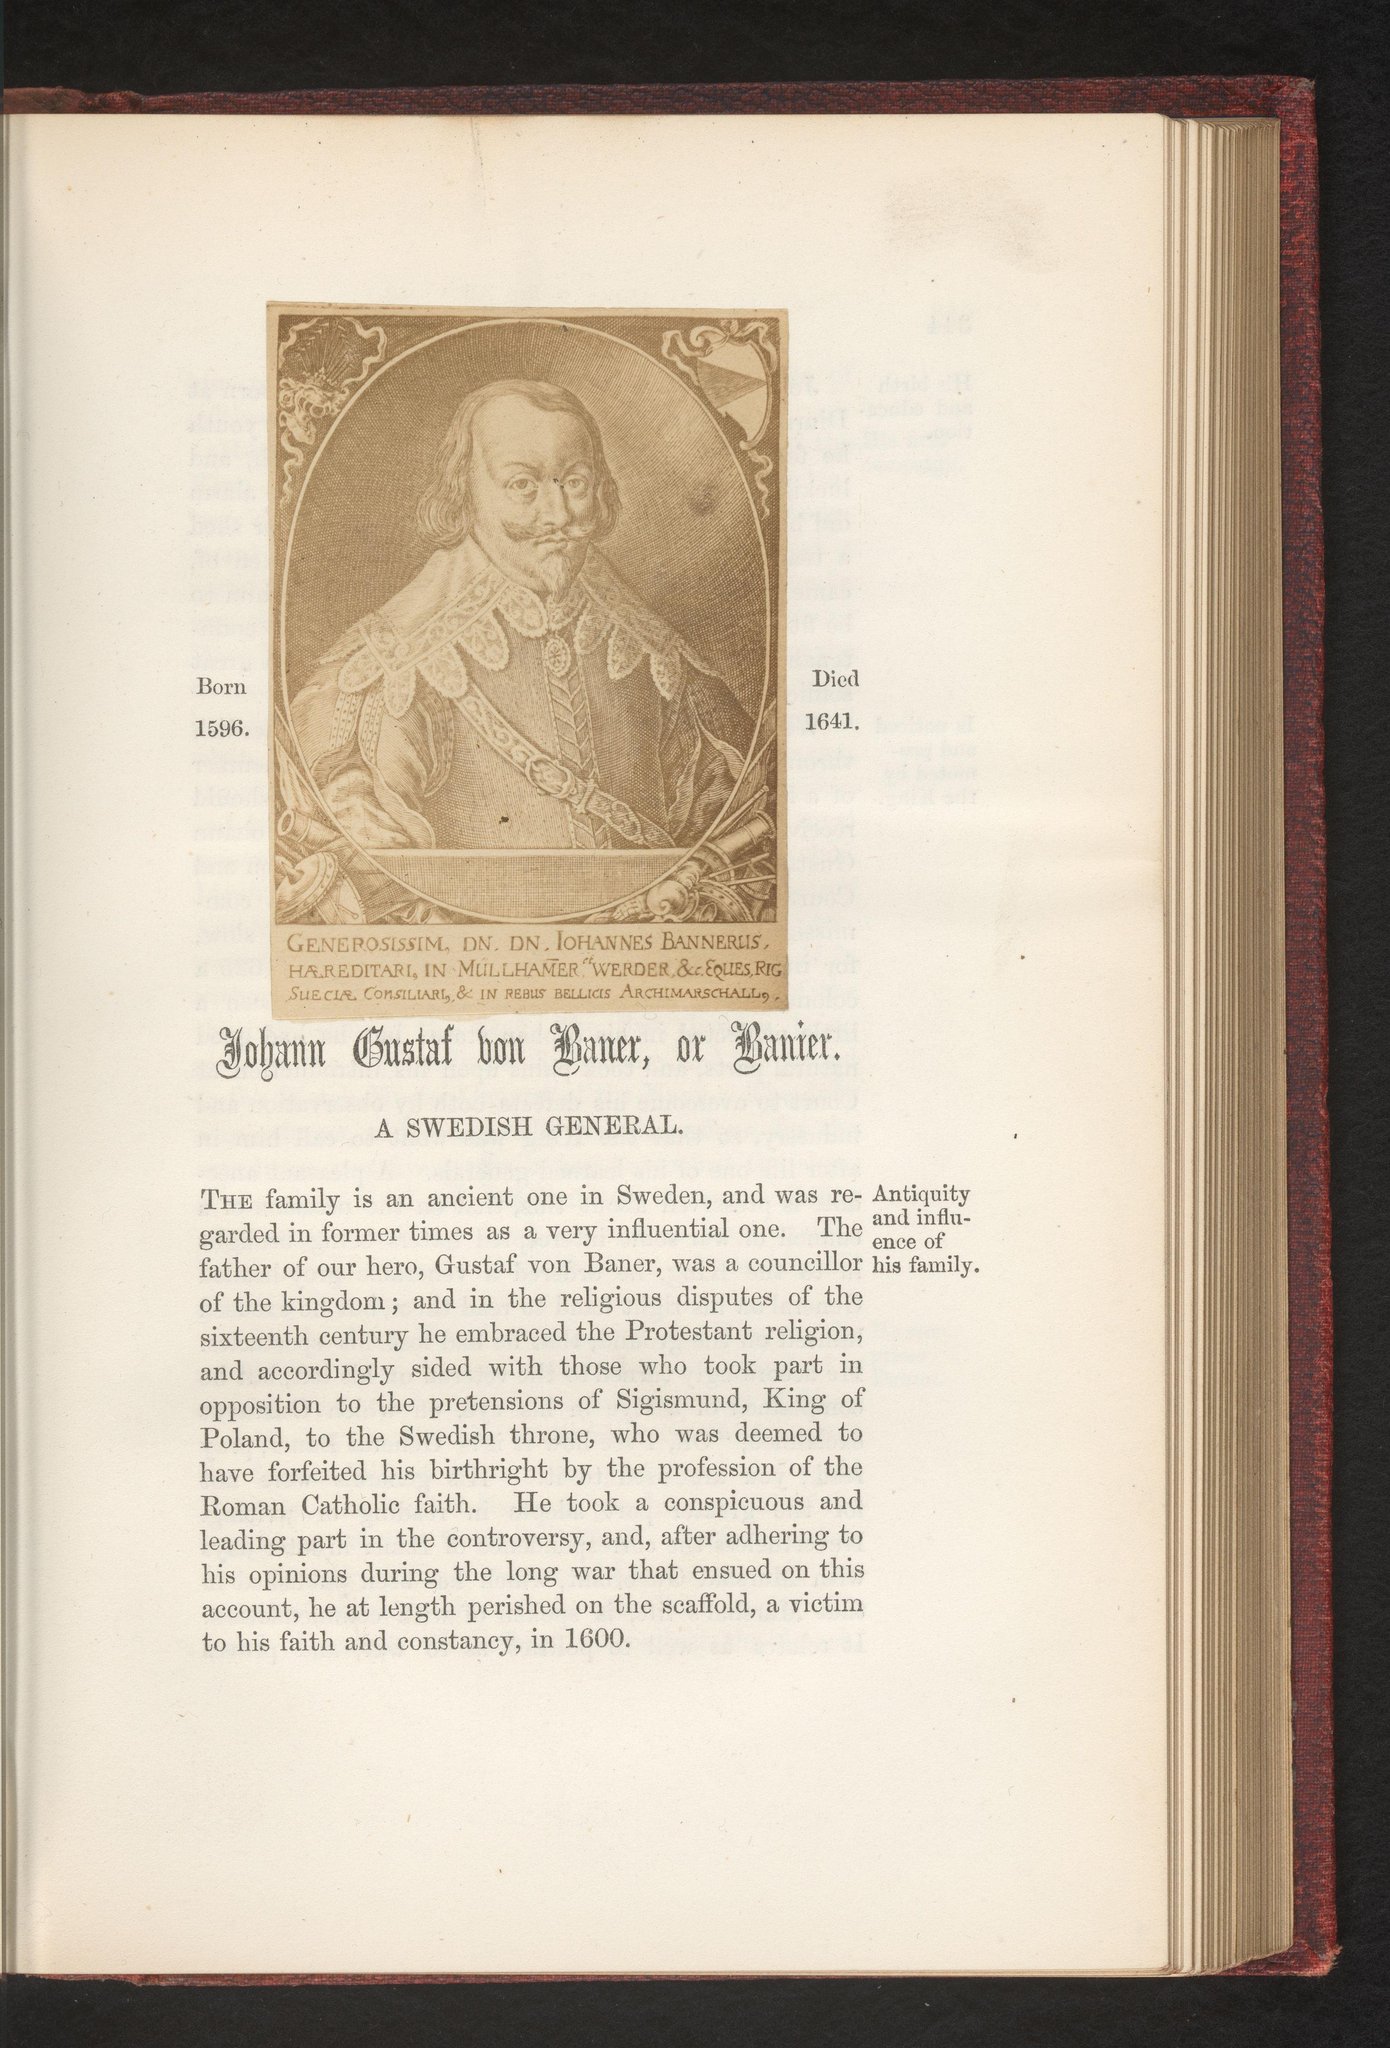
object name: reproduction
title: Johann Gustaf von Baner, or Banier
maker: Anonymous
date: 1860-1865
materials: photographic support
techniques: albumen print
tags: politician, historical persons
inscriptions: inscription: ‘Born 1596/ Died 1641/ A Swedish general’